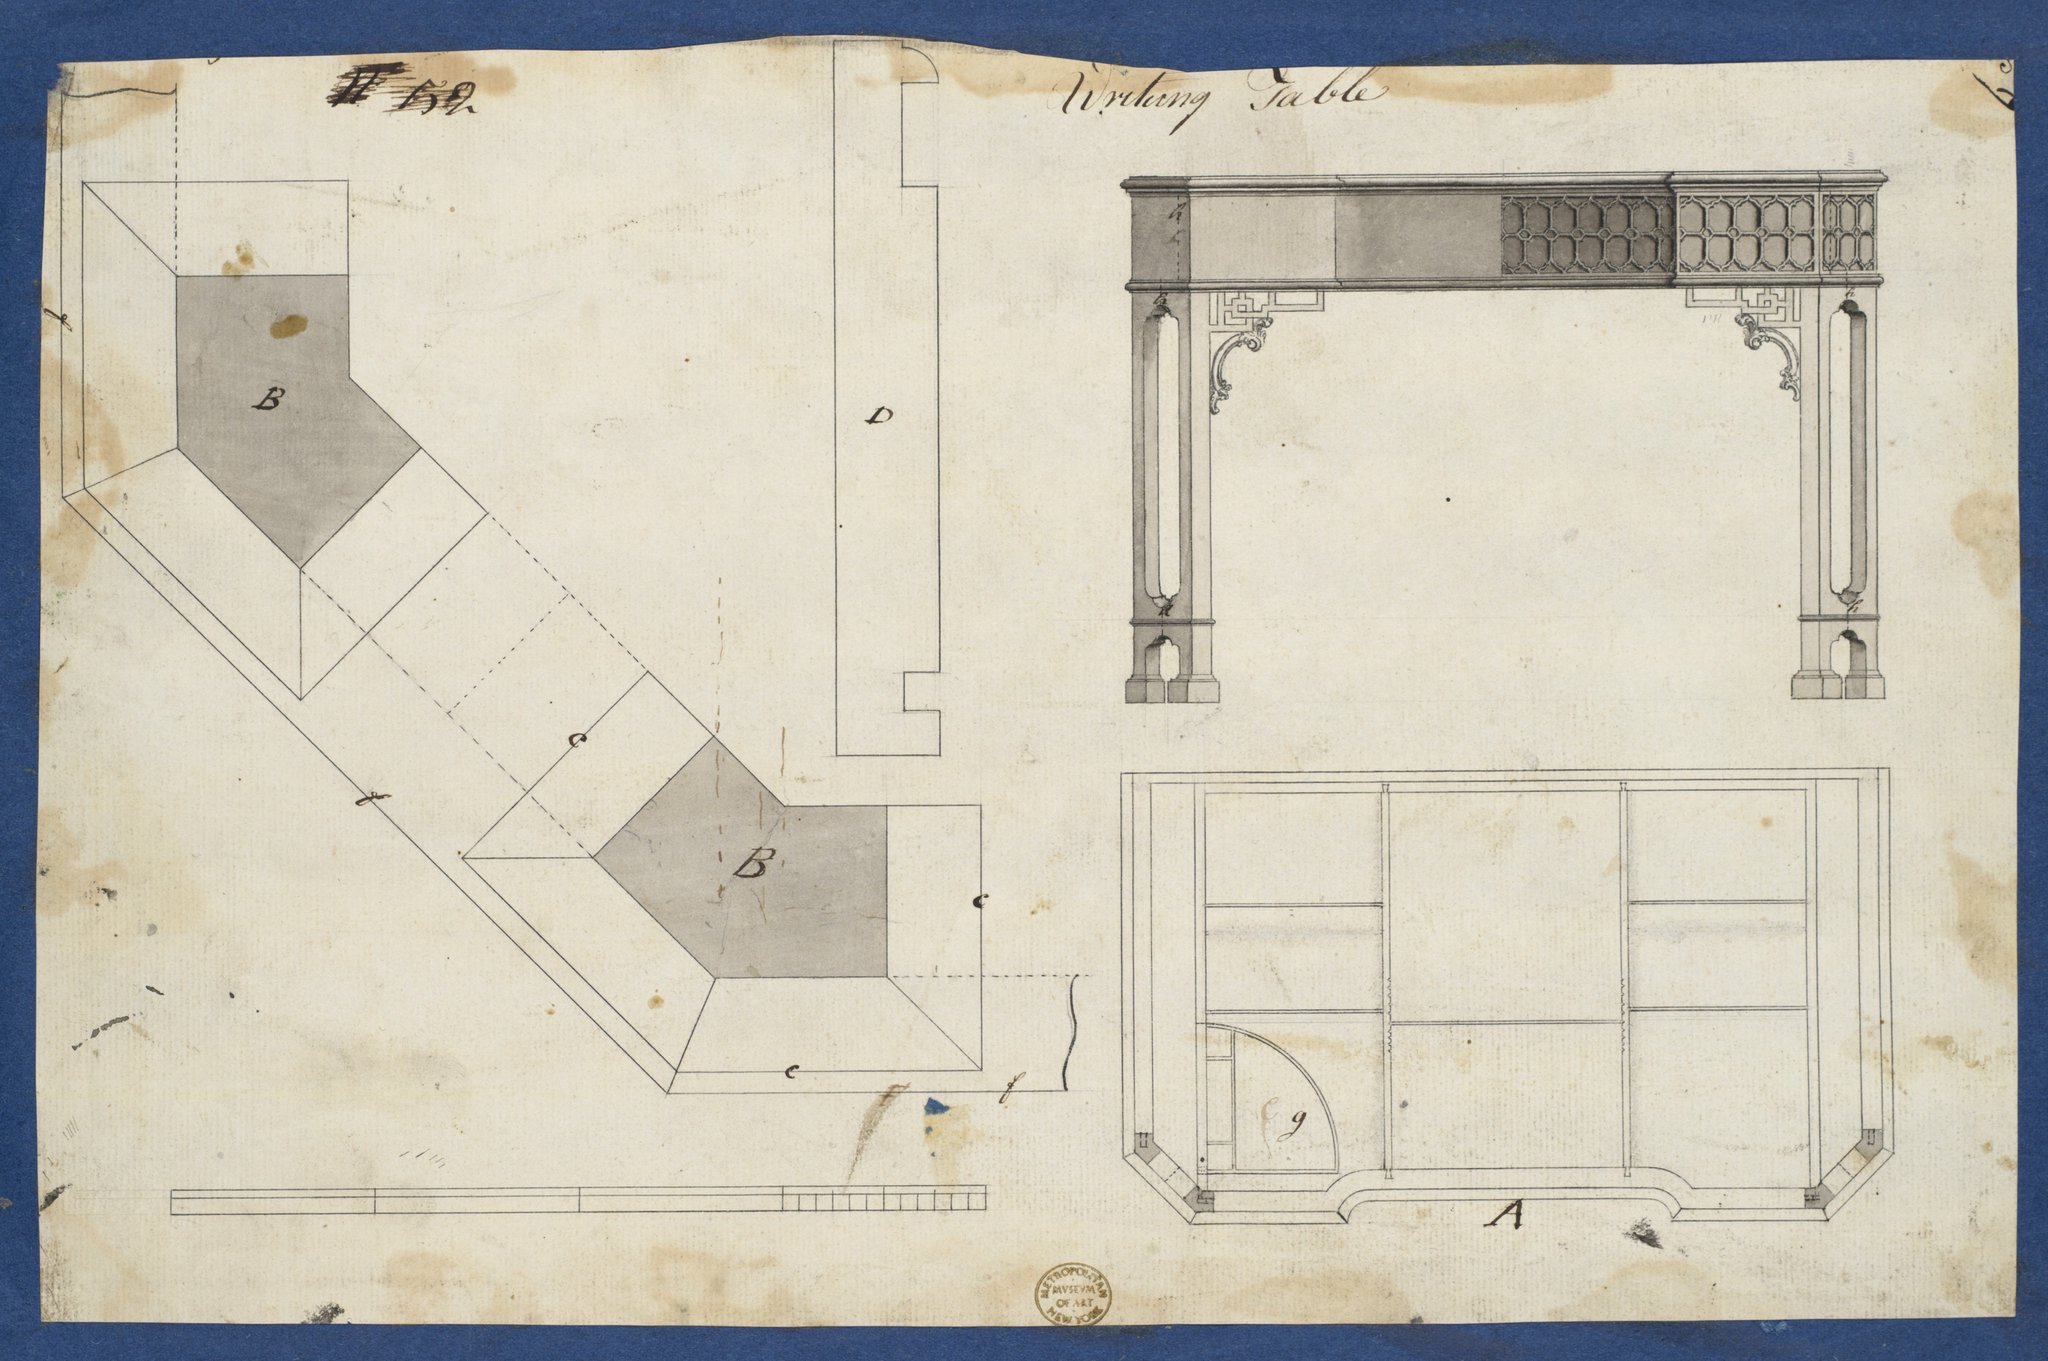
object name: drawing ornament architecture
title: Writing Table, from Chippendale Drawings, Vol. II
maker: thomas chippendale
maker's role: artist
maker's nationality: british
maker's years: 1718-1779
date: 1753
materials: ink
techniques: wash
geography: london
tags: tables